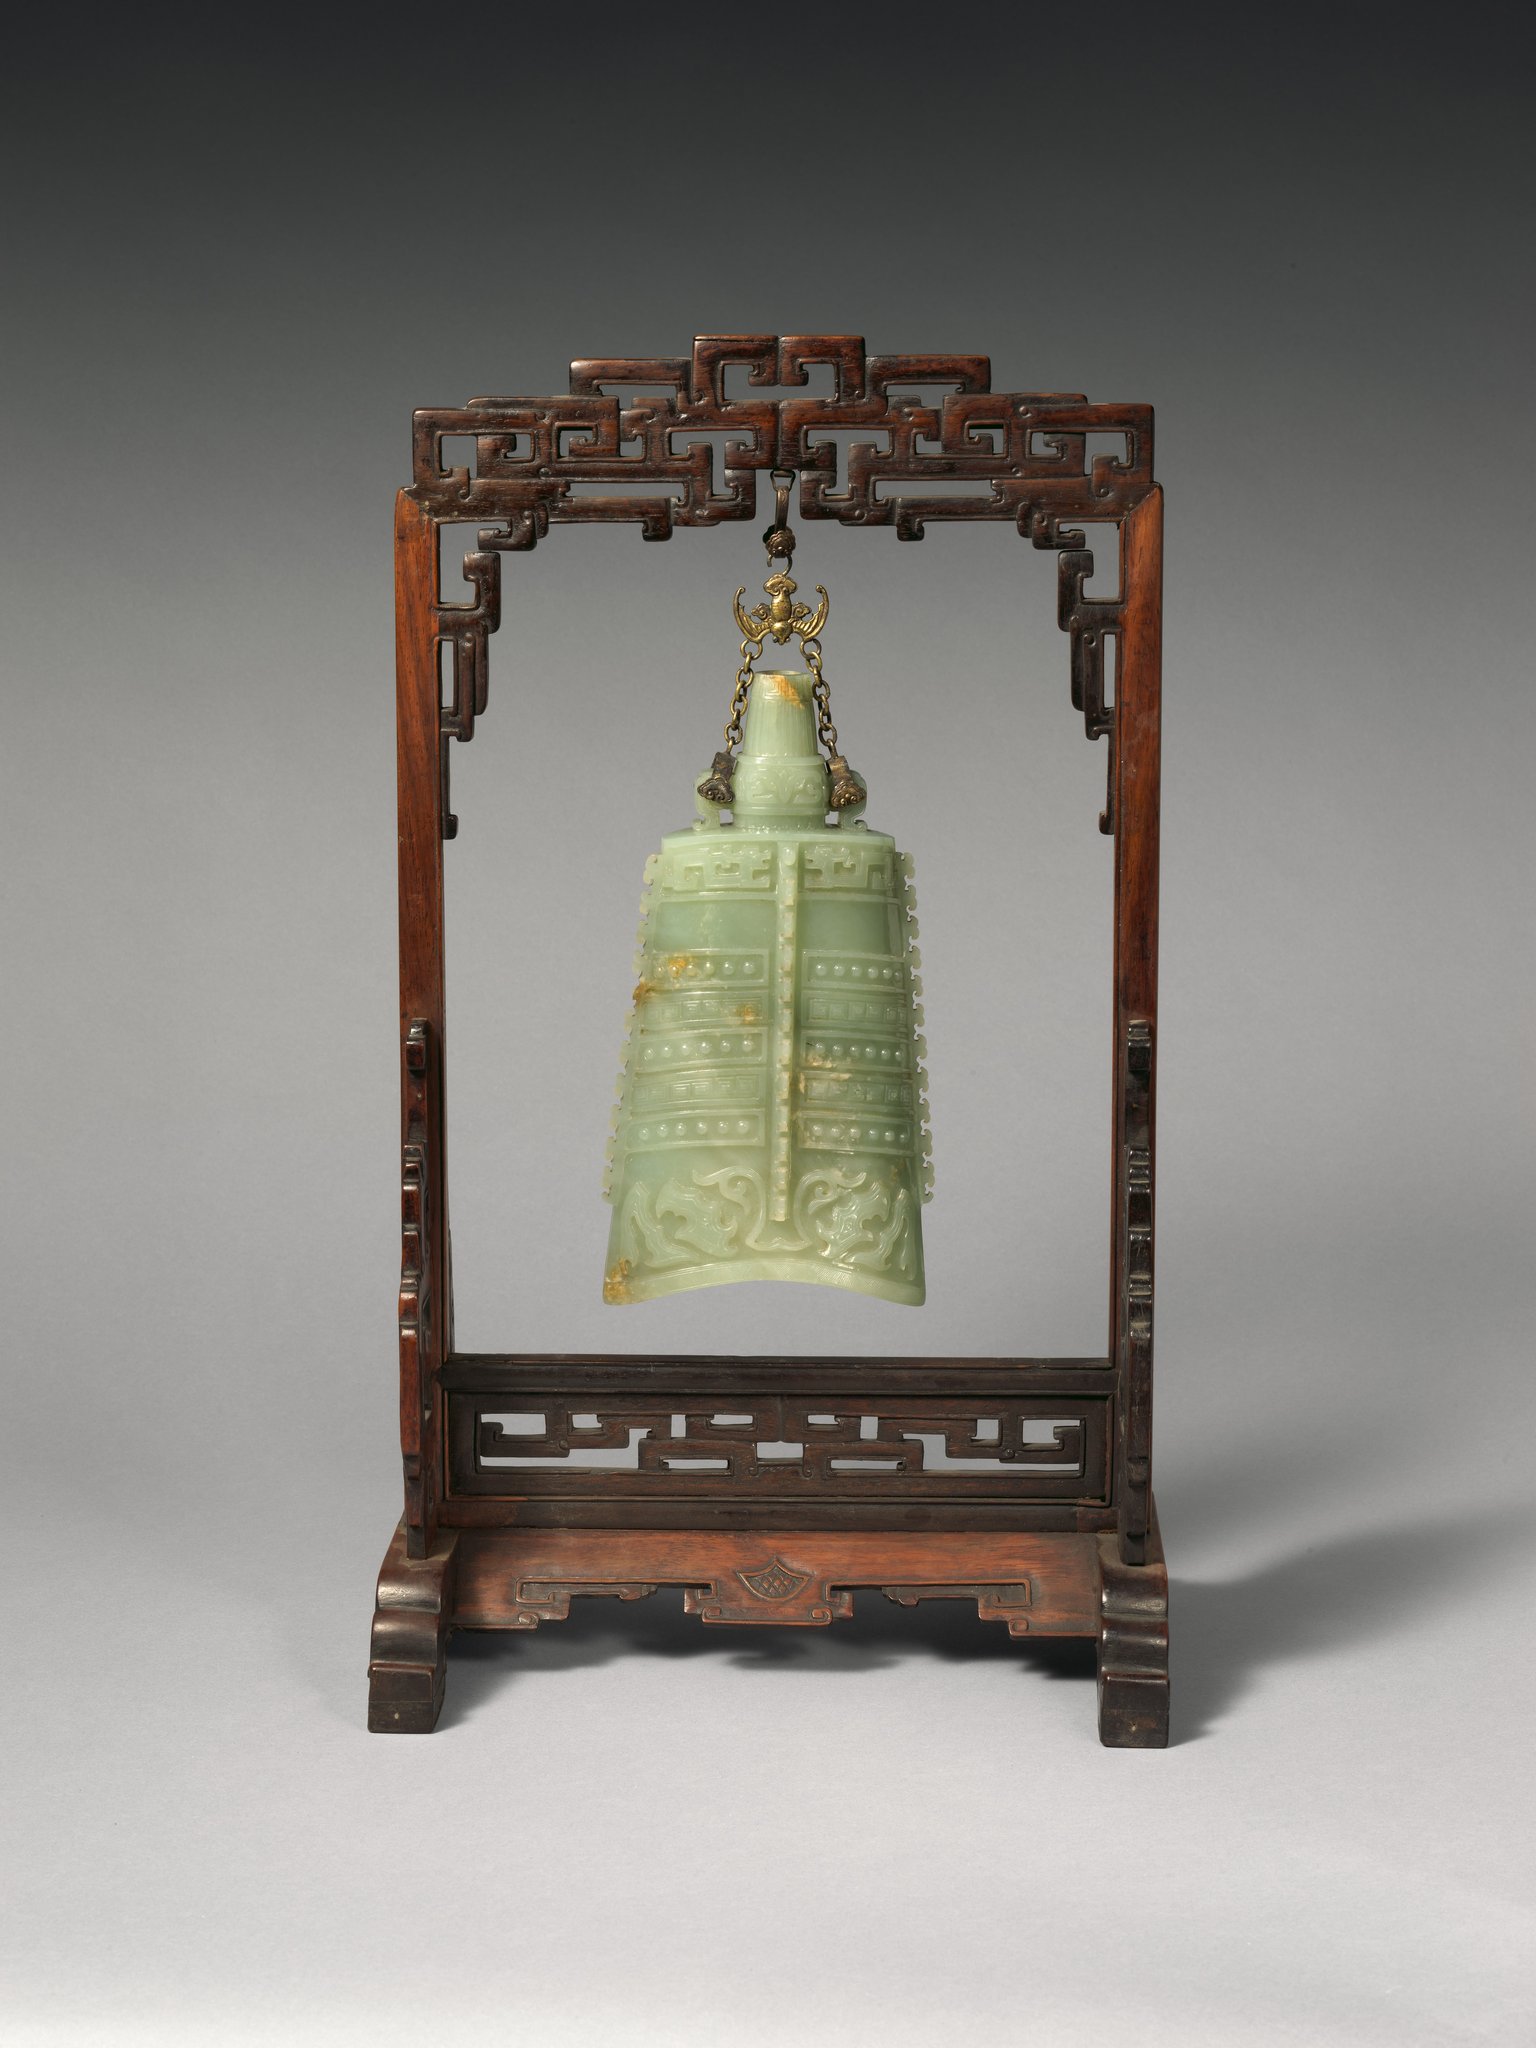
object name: bell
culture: chinese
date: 1701-1900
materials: jade